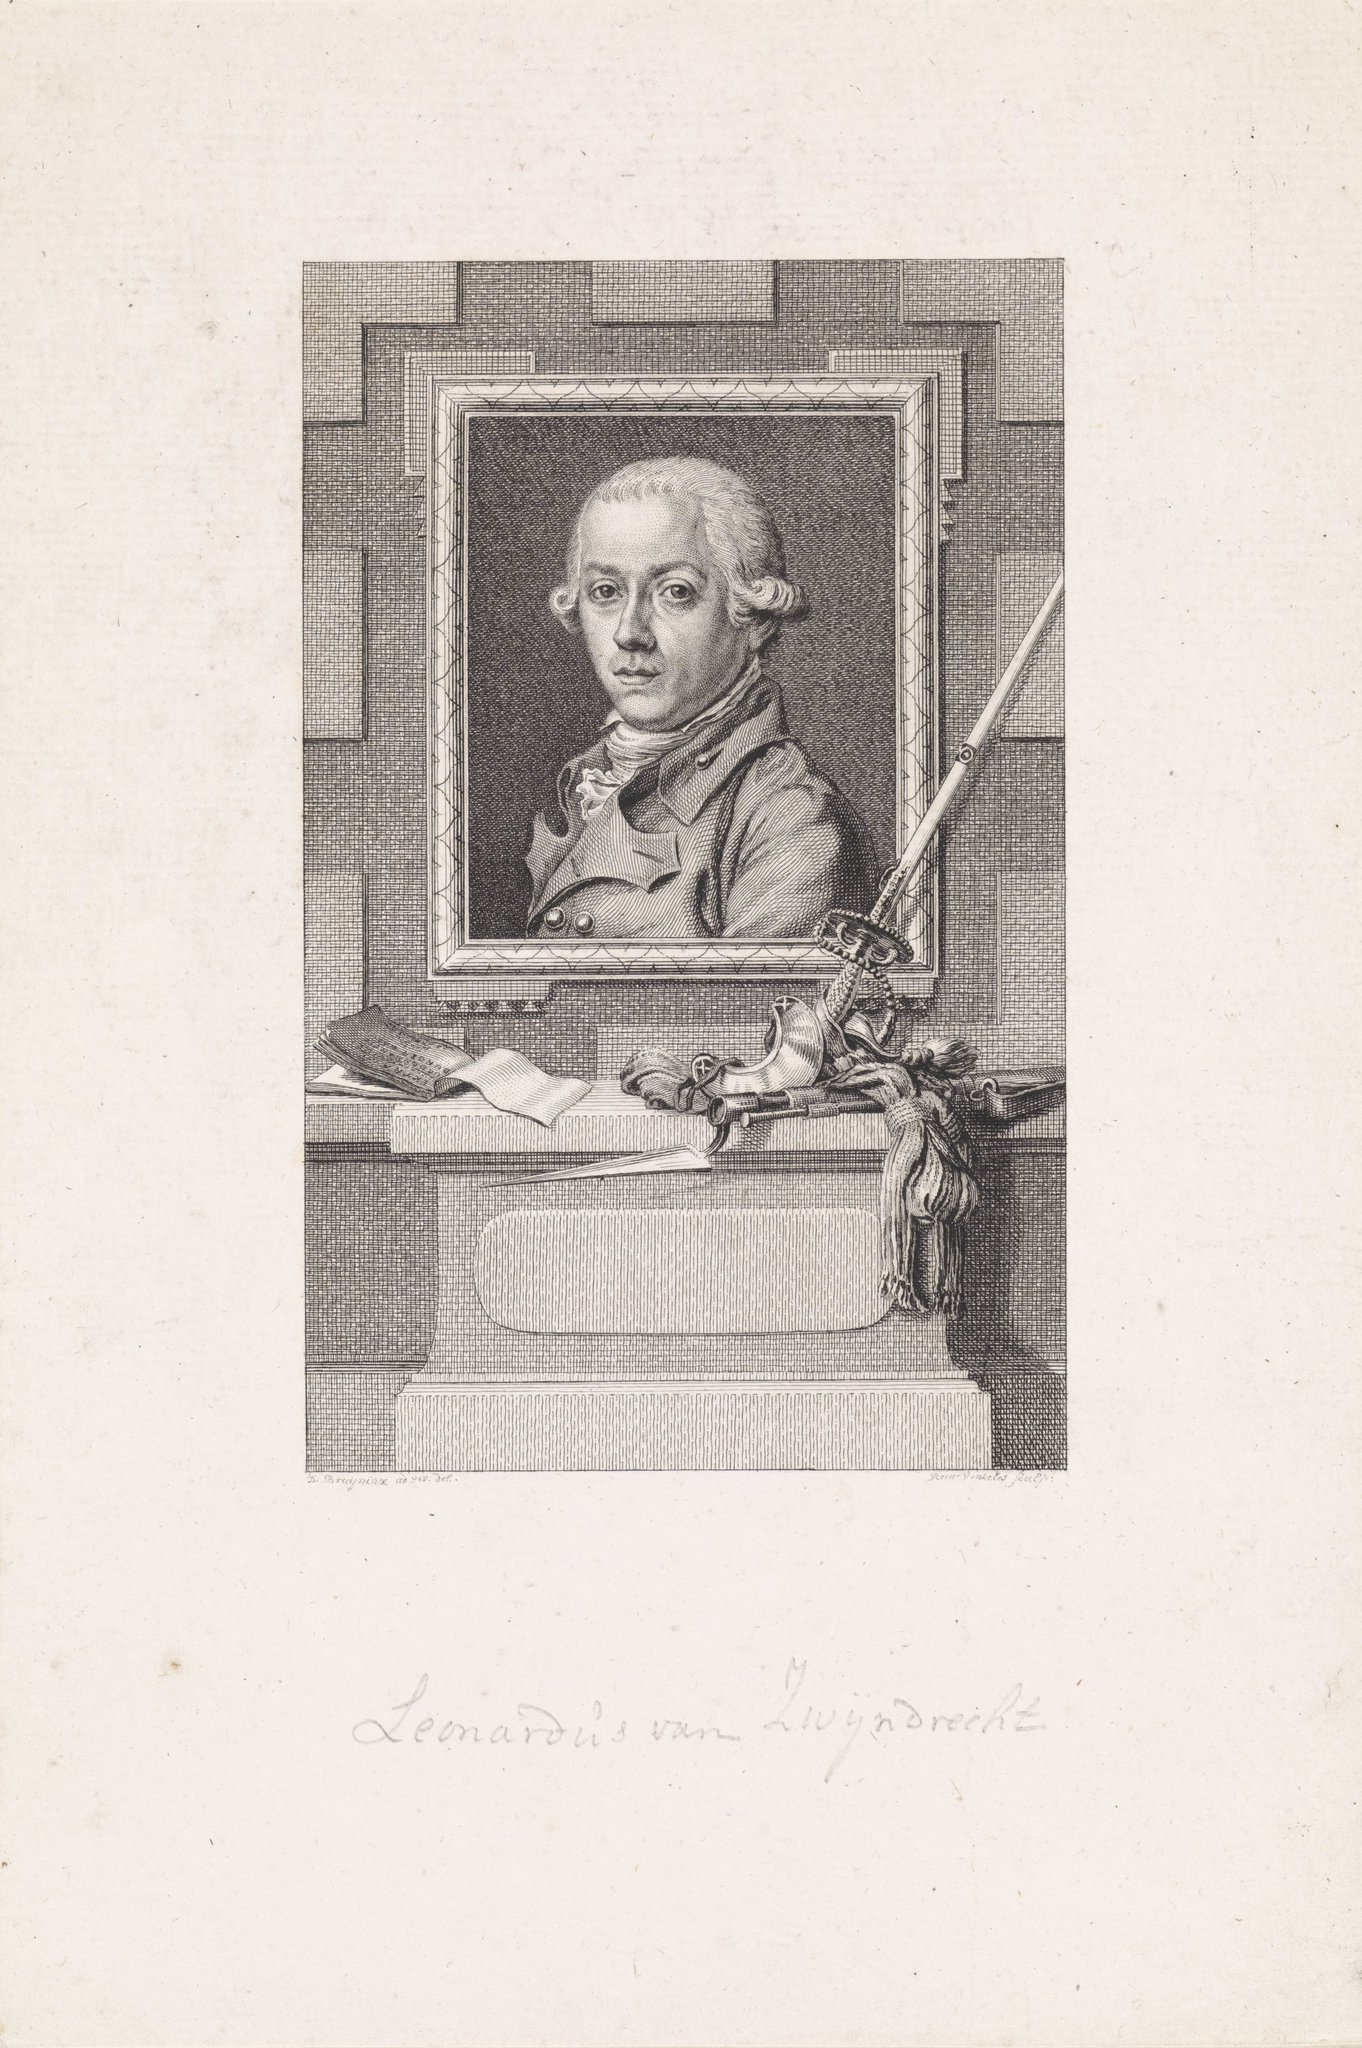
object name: print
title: Portret van Leonardus van Zwijndregt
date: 1792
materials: paper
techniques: engraving, etching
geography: amsterdam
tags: helved weapons, polearms (for striking, hacking, thrusting) (with name), book, hacking and thrusting weapons: rapier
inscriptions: collector's mark: Lugt 240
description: Prent waarschijnlijk uit: Wagenaar, Jan. Vaderlandsche Historie, Vervattende De Geschiedenissen Vereenigde Nederlanden (...). Amsterdam: Johannes Allart, 1792, dl. 8.